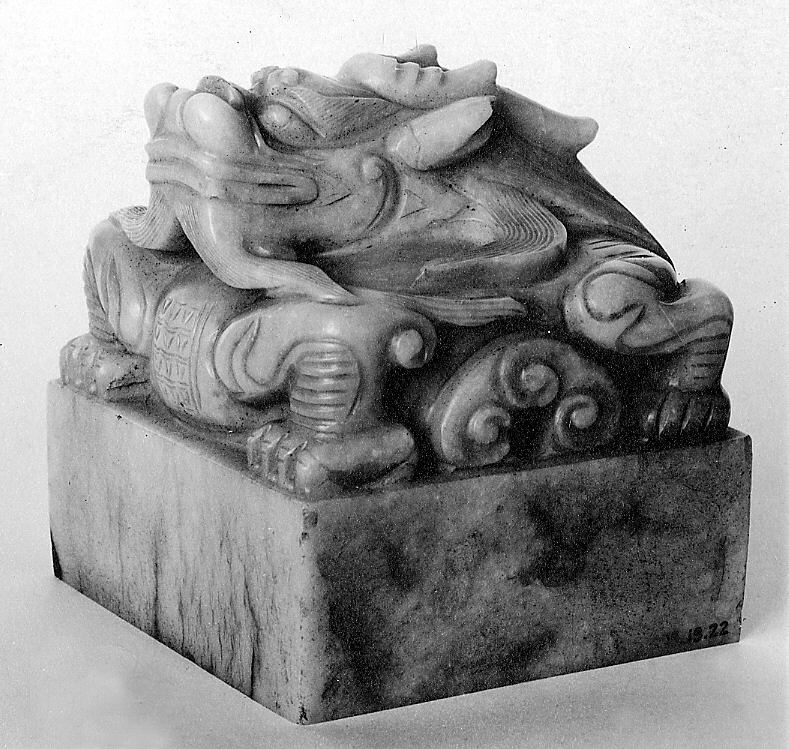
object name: seal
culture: chinese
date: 960-1279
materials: jade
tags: dragons